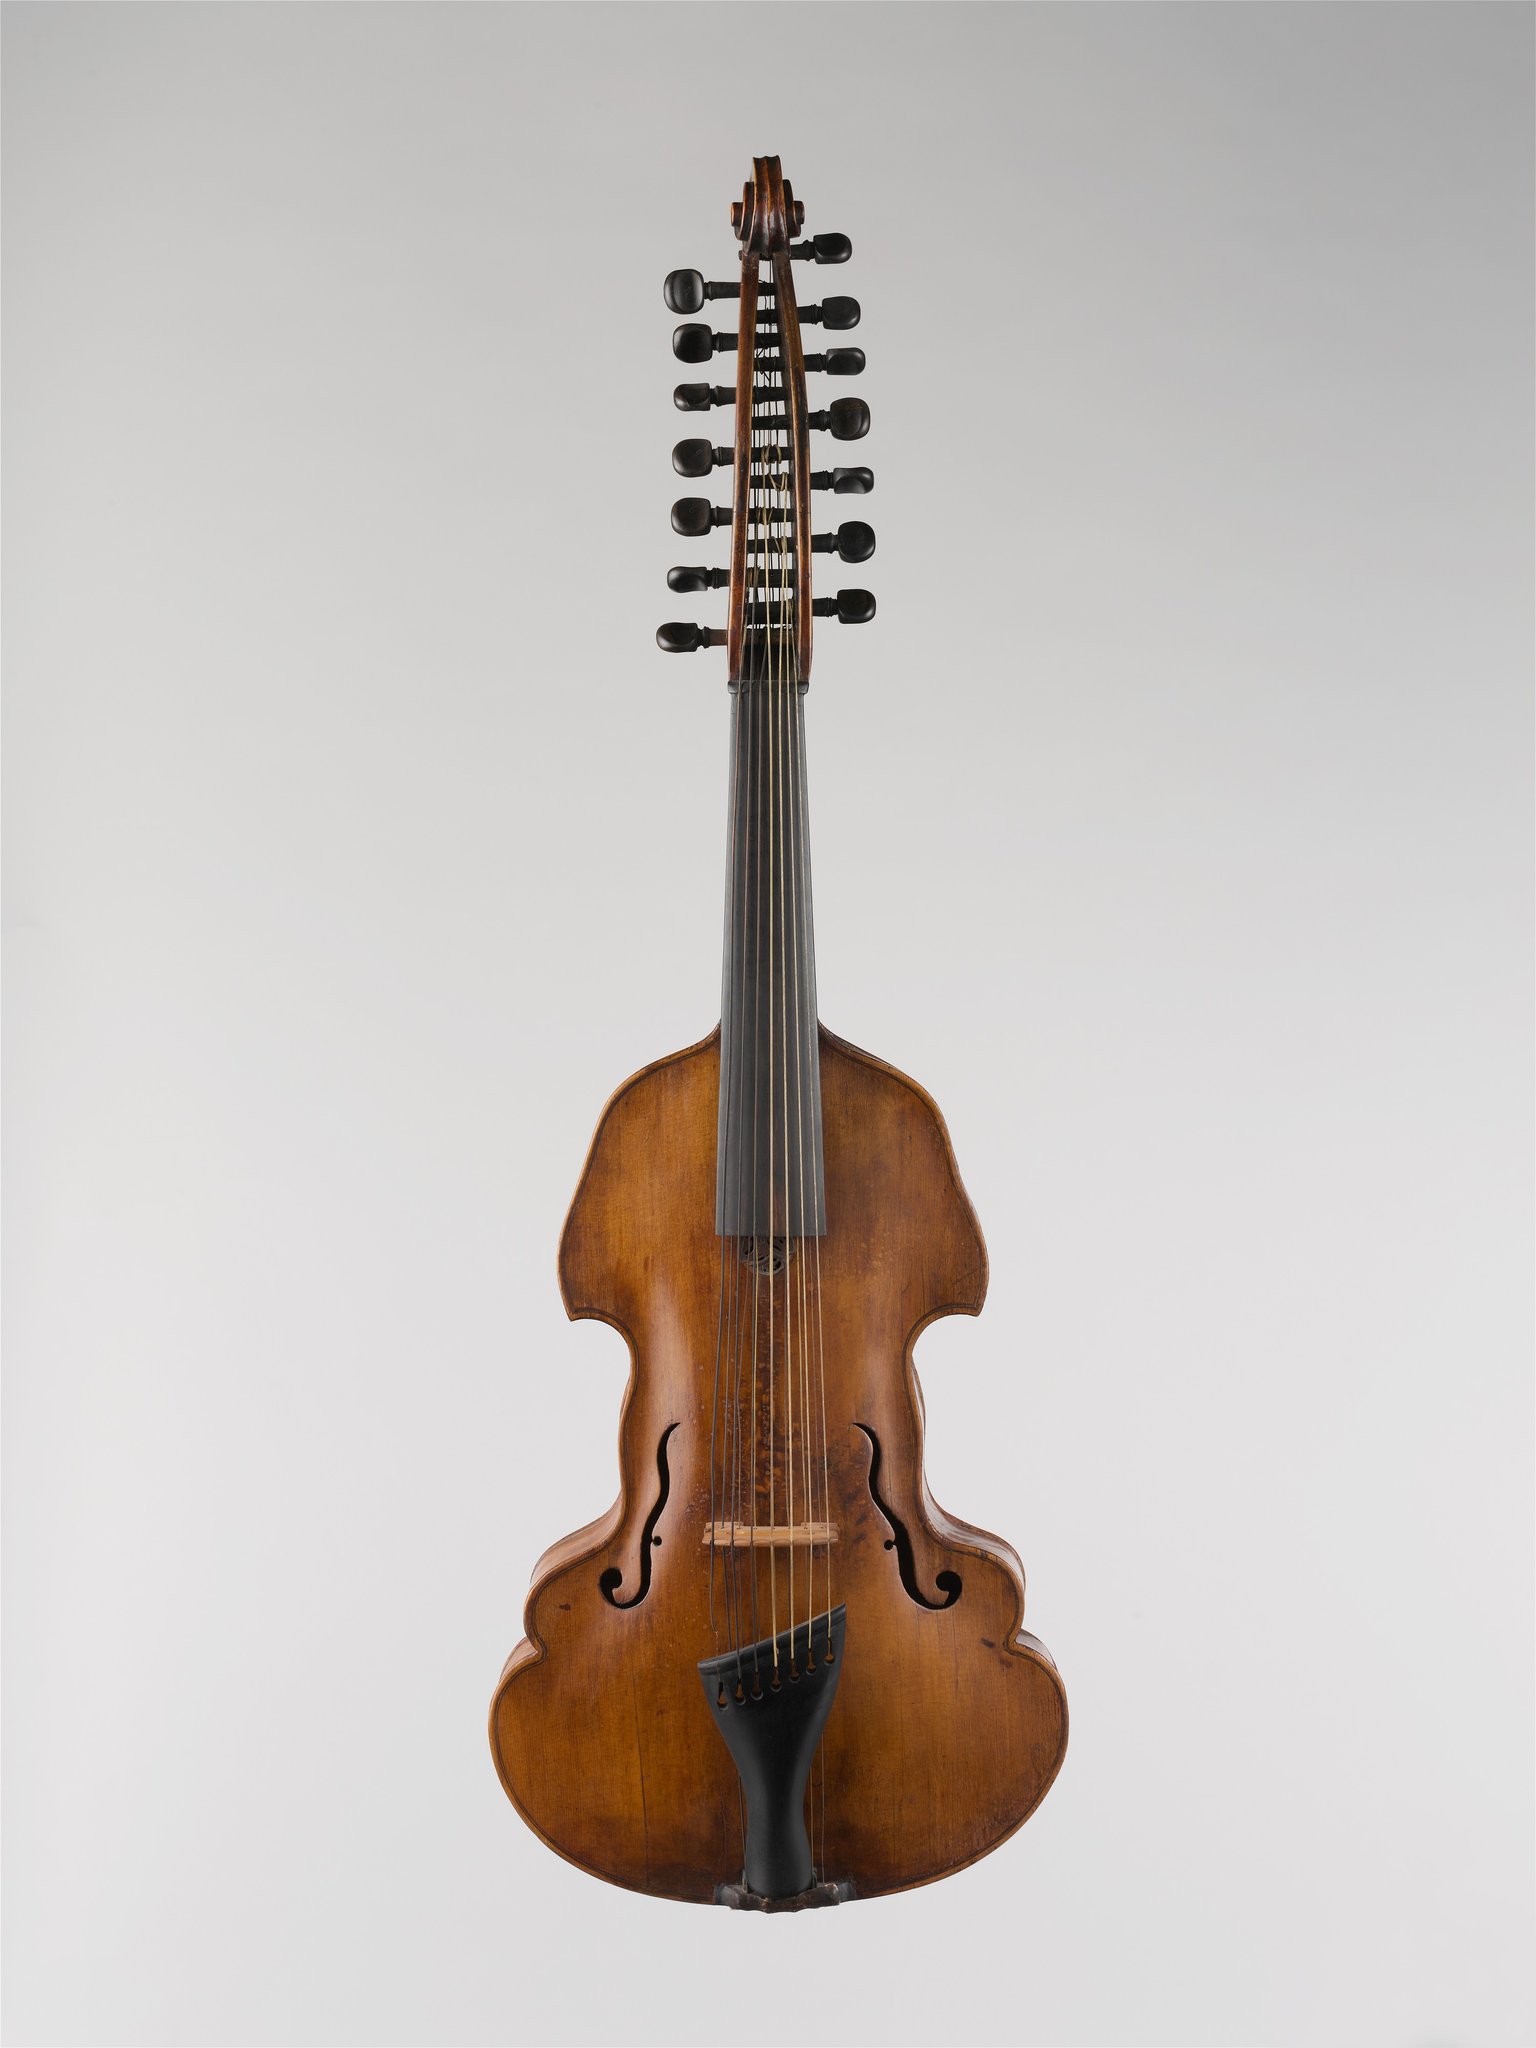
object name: viola d'amore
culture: german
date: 1739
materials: wood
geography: germany